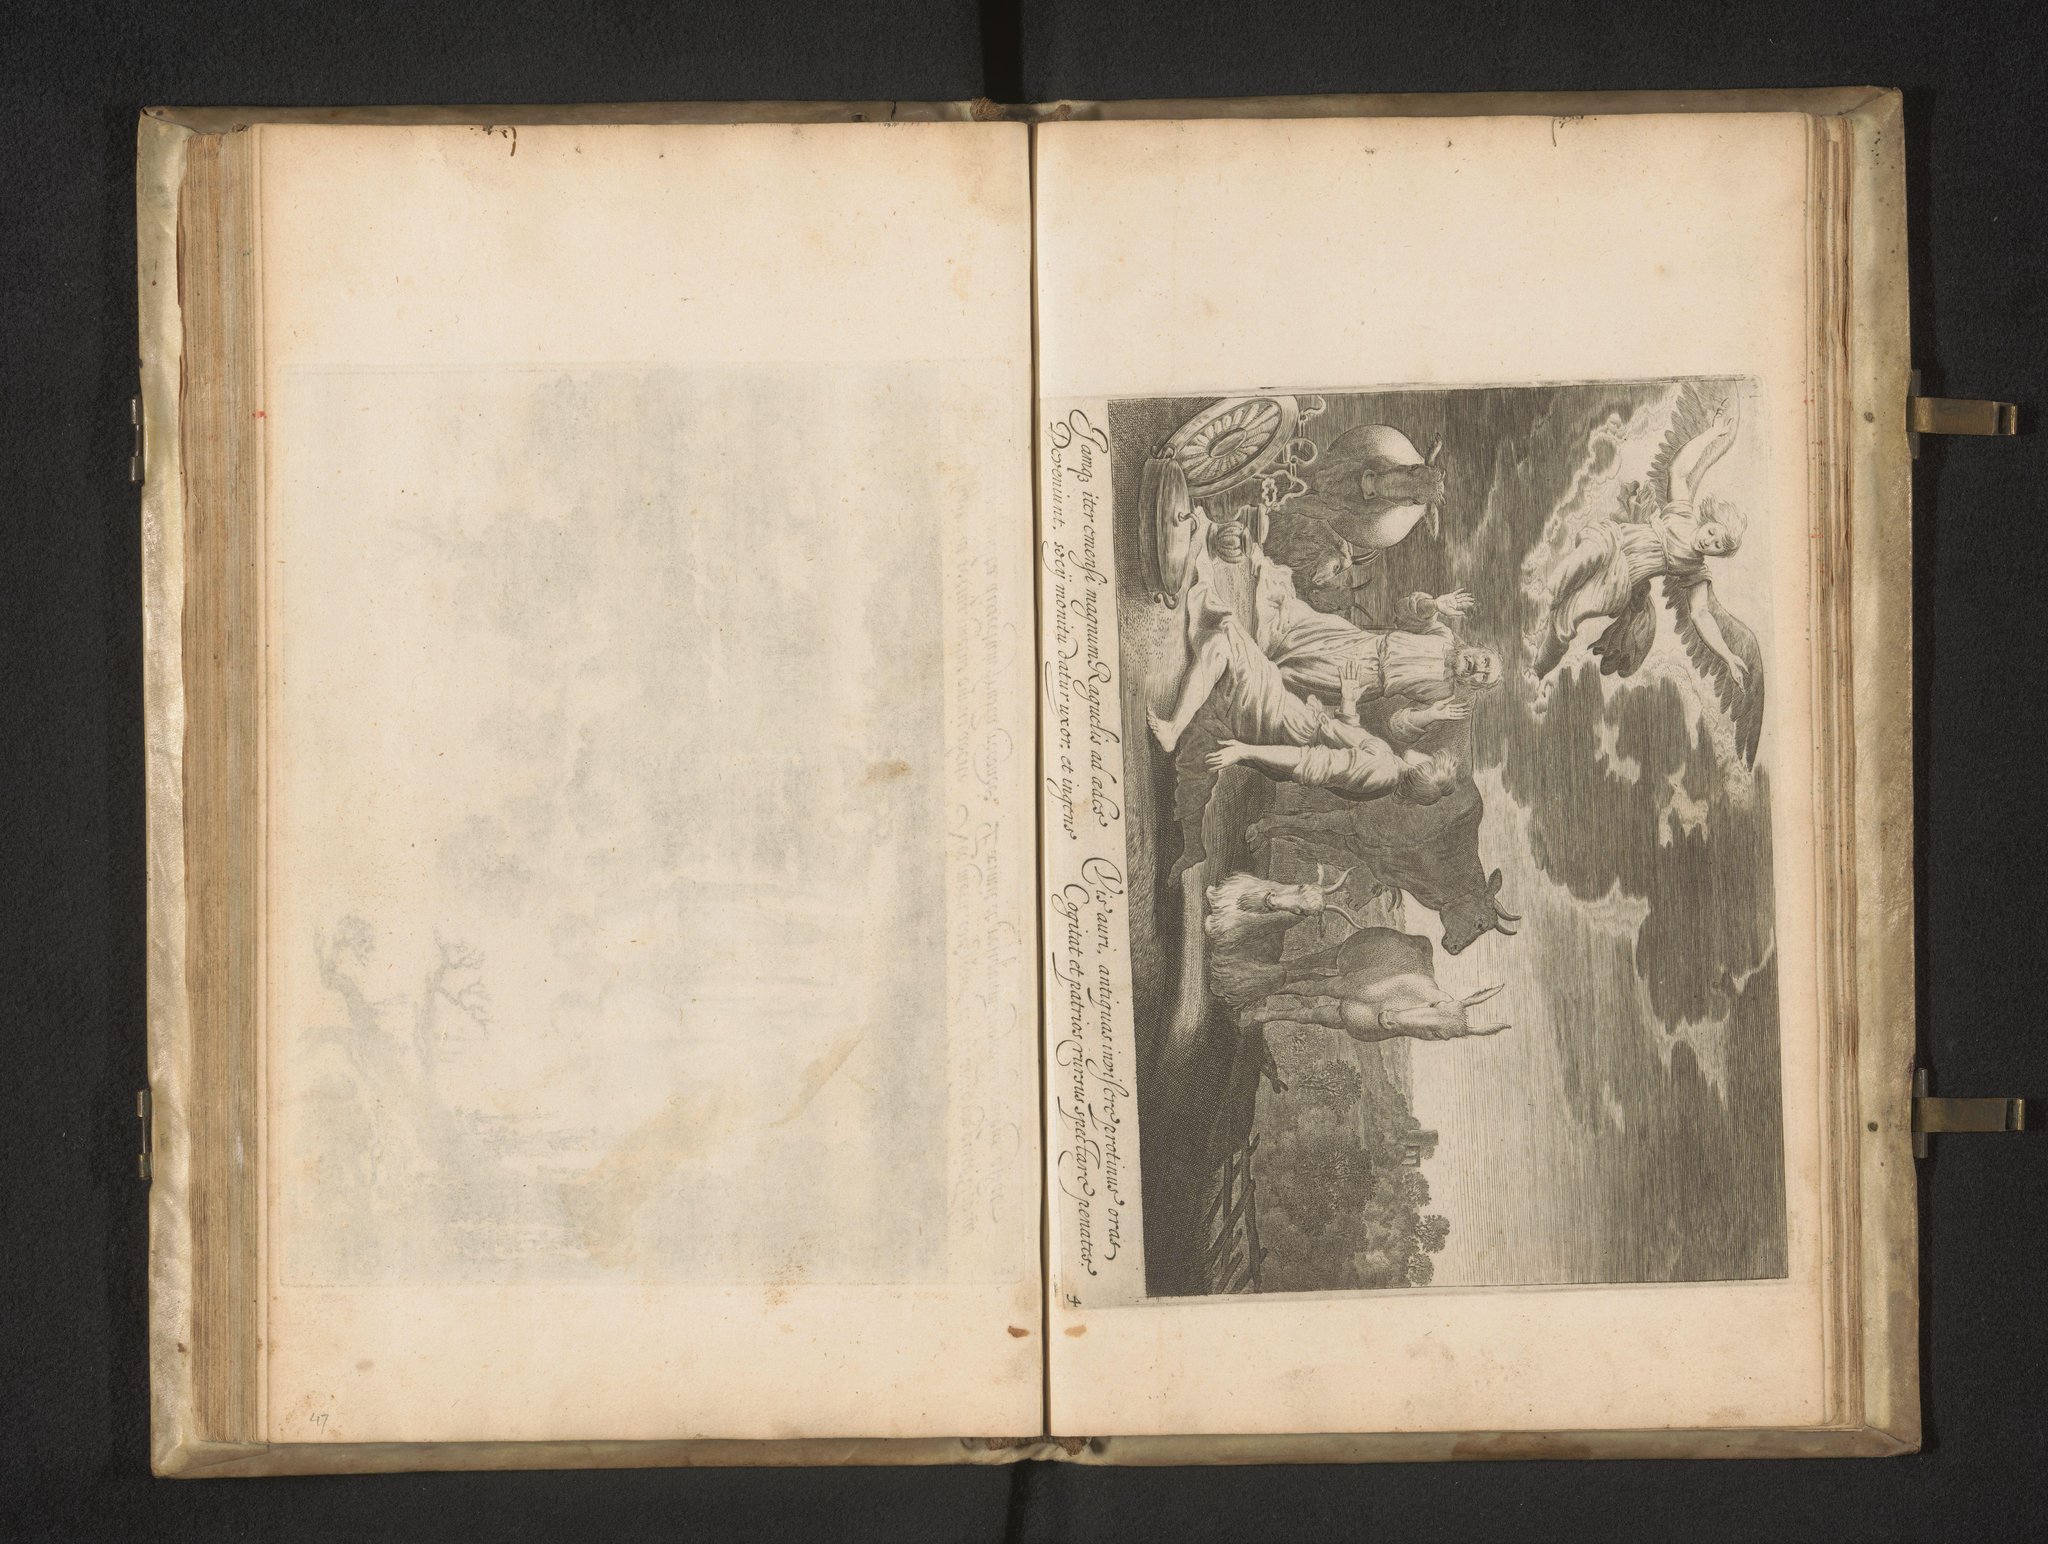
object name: print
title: Verhaal van Tobias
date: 1603-1641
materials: paper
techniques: engraving, etching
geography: amsterdam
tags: the angel raphael disappears into the sky, tobias and his father offer gifts to the angel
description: Tobias en Tobit willen de reisgenoot bedanken met geschenken, waarop de engel Rafaël zichzelf bekend maakt en hen verlaat door op te stijgen. Vierde prent uit een serie van vier over het bijbelverhaal van Tobias. Rechtsonder genummerd: 4. Onderaan in de marge een onderschrift van vier regels in het Latijn. Onderdeel van een album met voornamelijk christelijke voorstellingen.